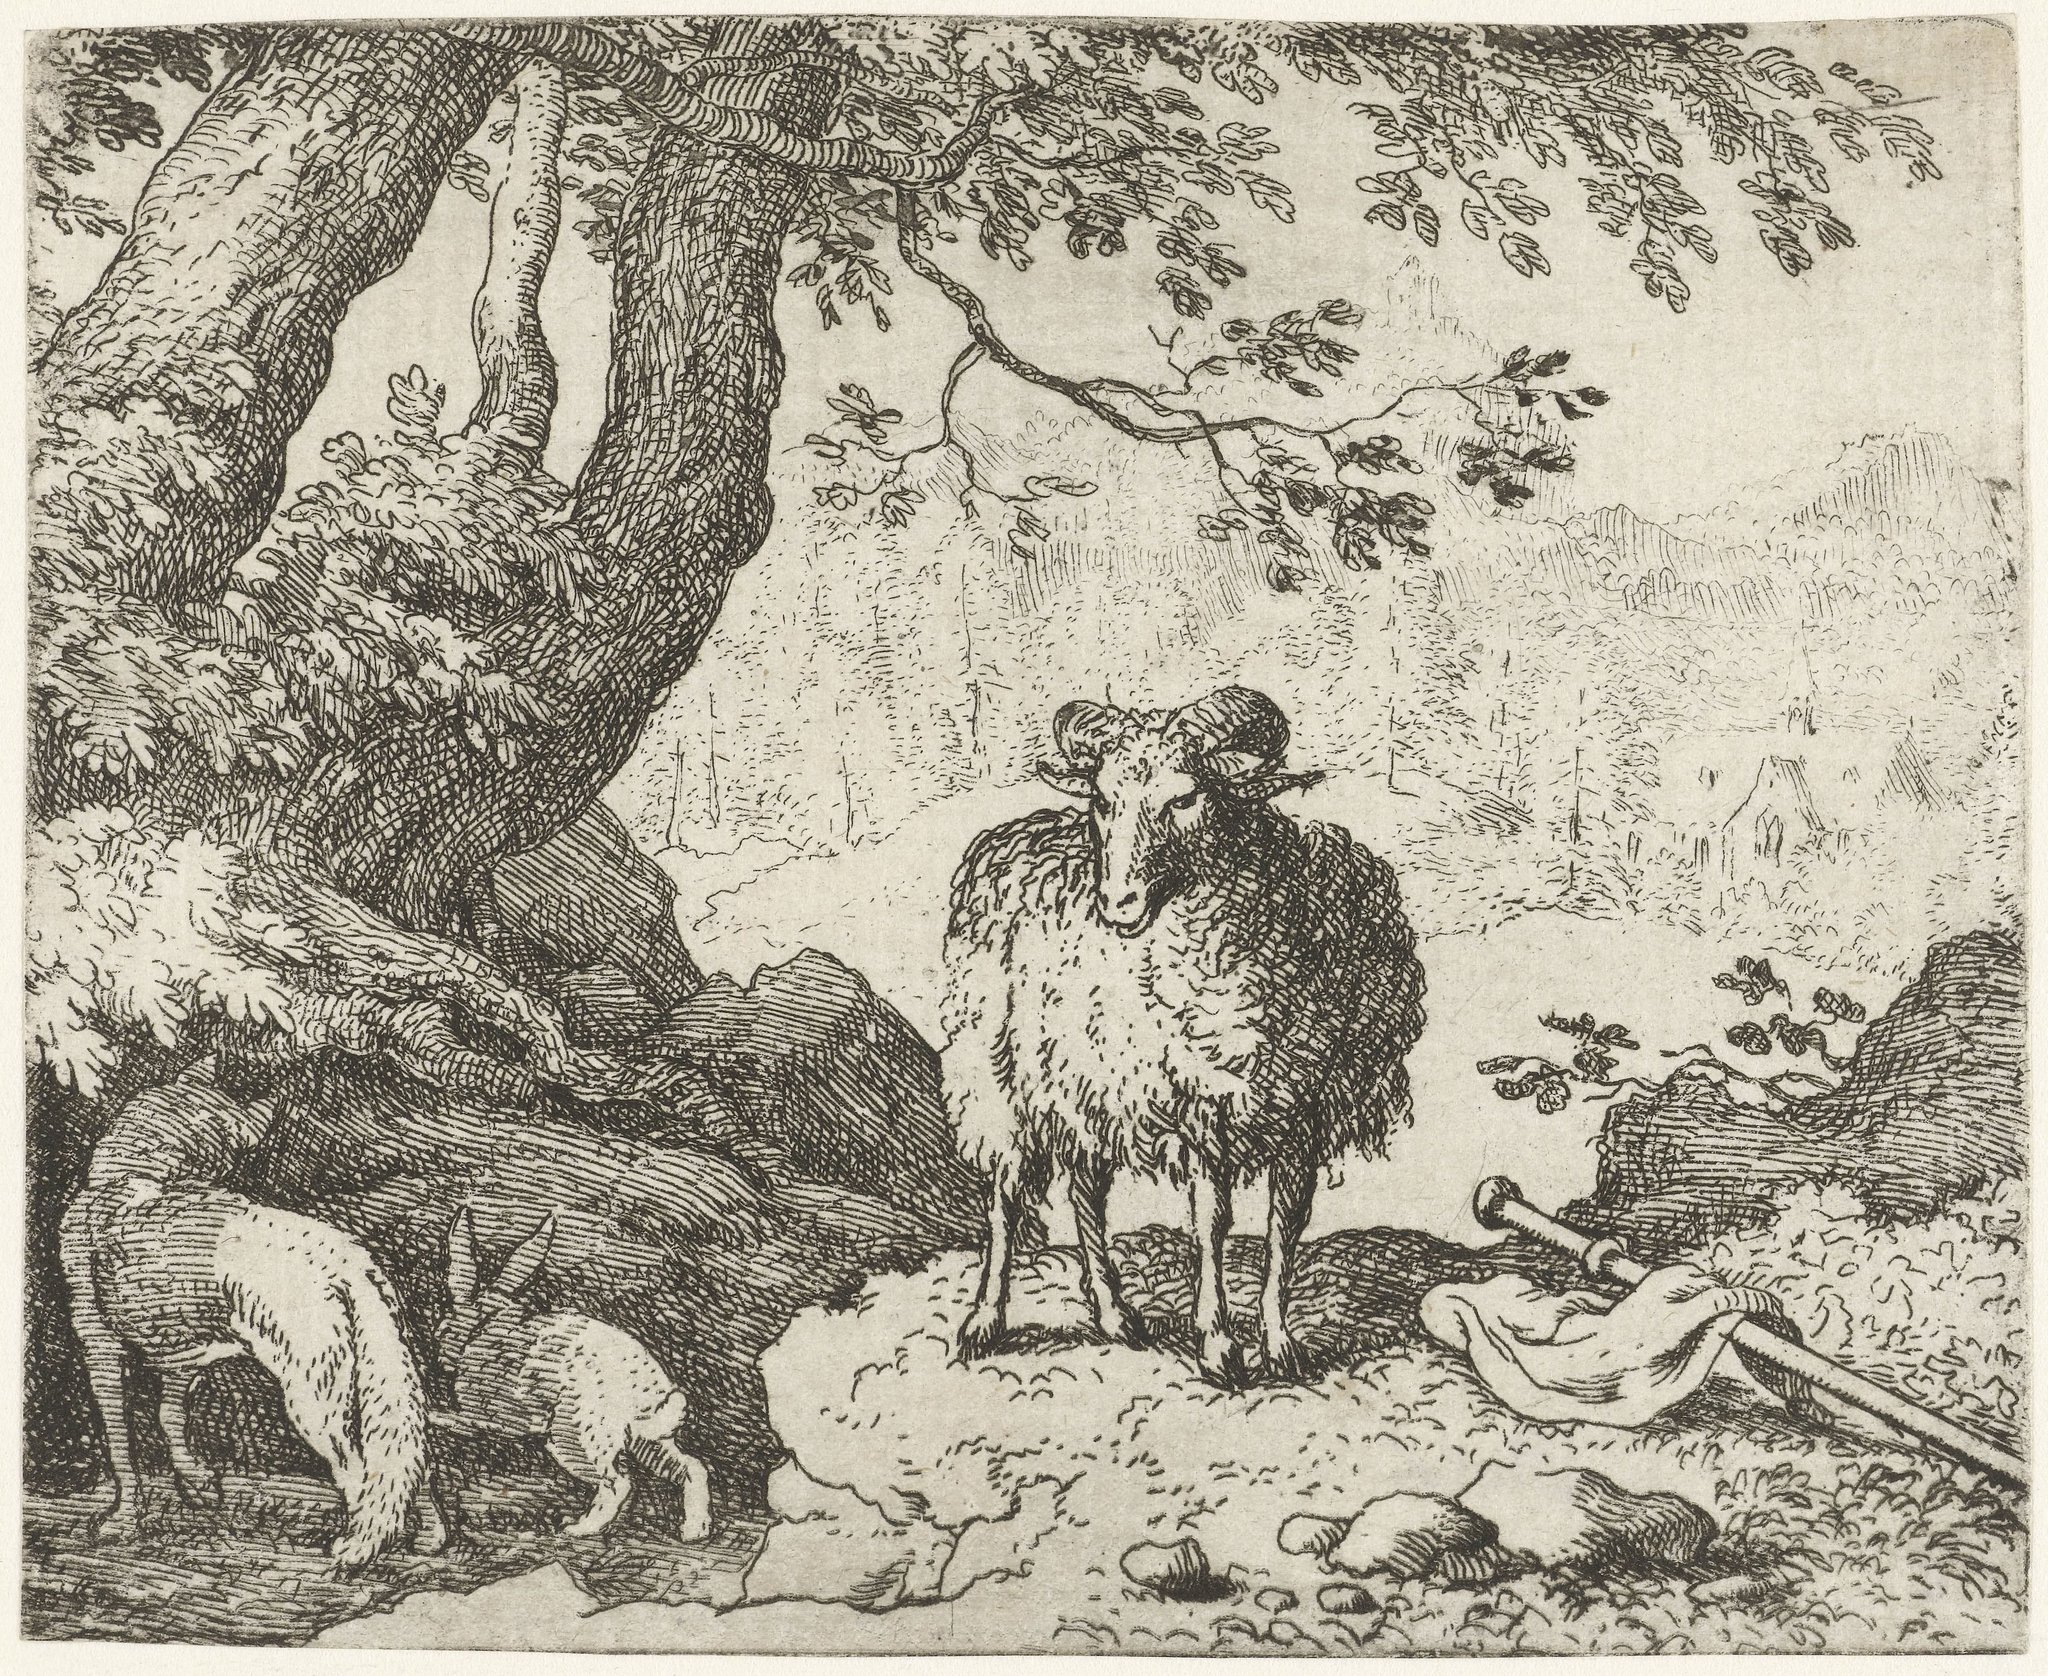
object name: print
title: Reinaert de vos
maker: allaert van everdingen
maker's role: draughtsman, painter, print maker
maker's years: 1621-1675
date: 1665-1675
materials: paper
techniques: etching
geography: netherlands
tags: fable of reynard the fox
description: Reinaert de vos lokt Cuwaert de haas mee zijn hol in, terwijl Belijn de ram buiten blijft wachten.